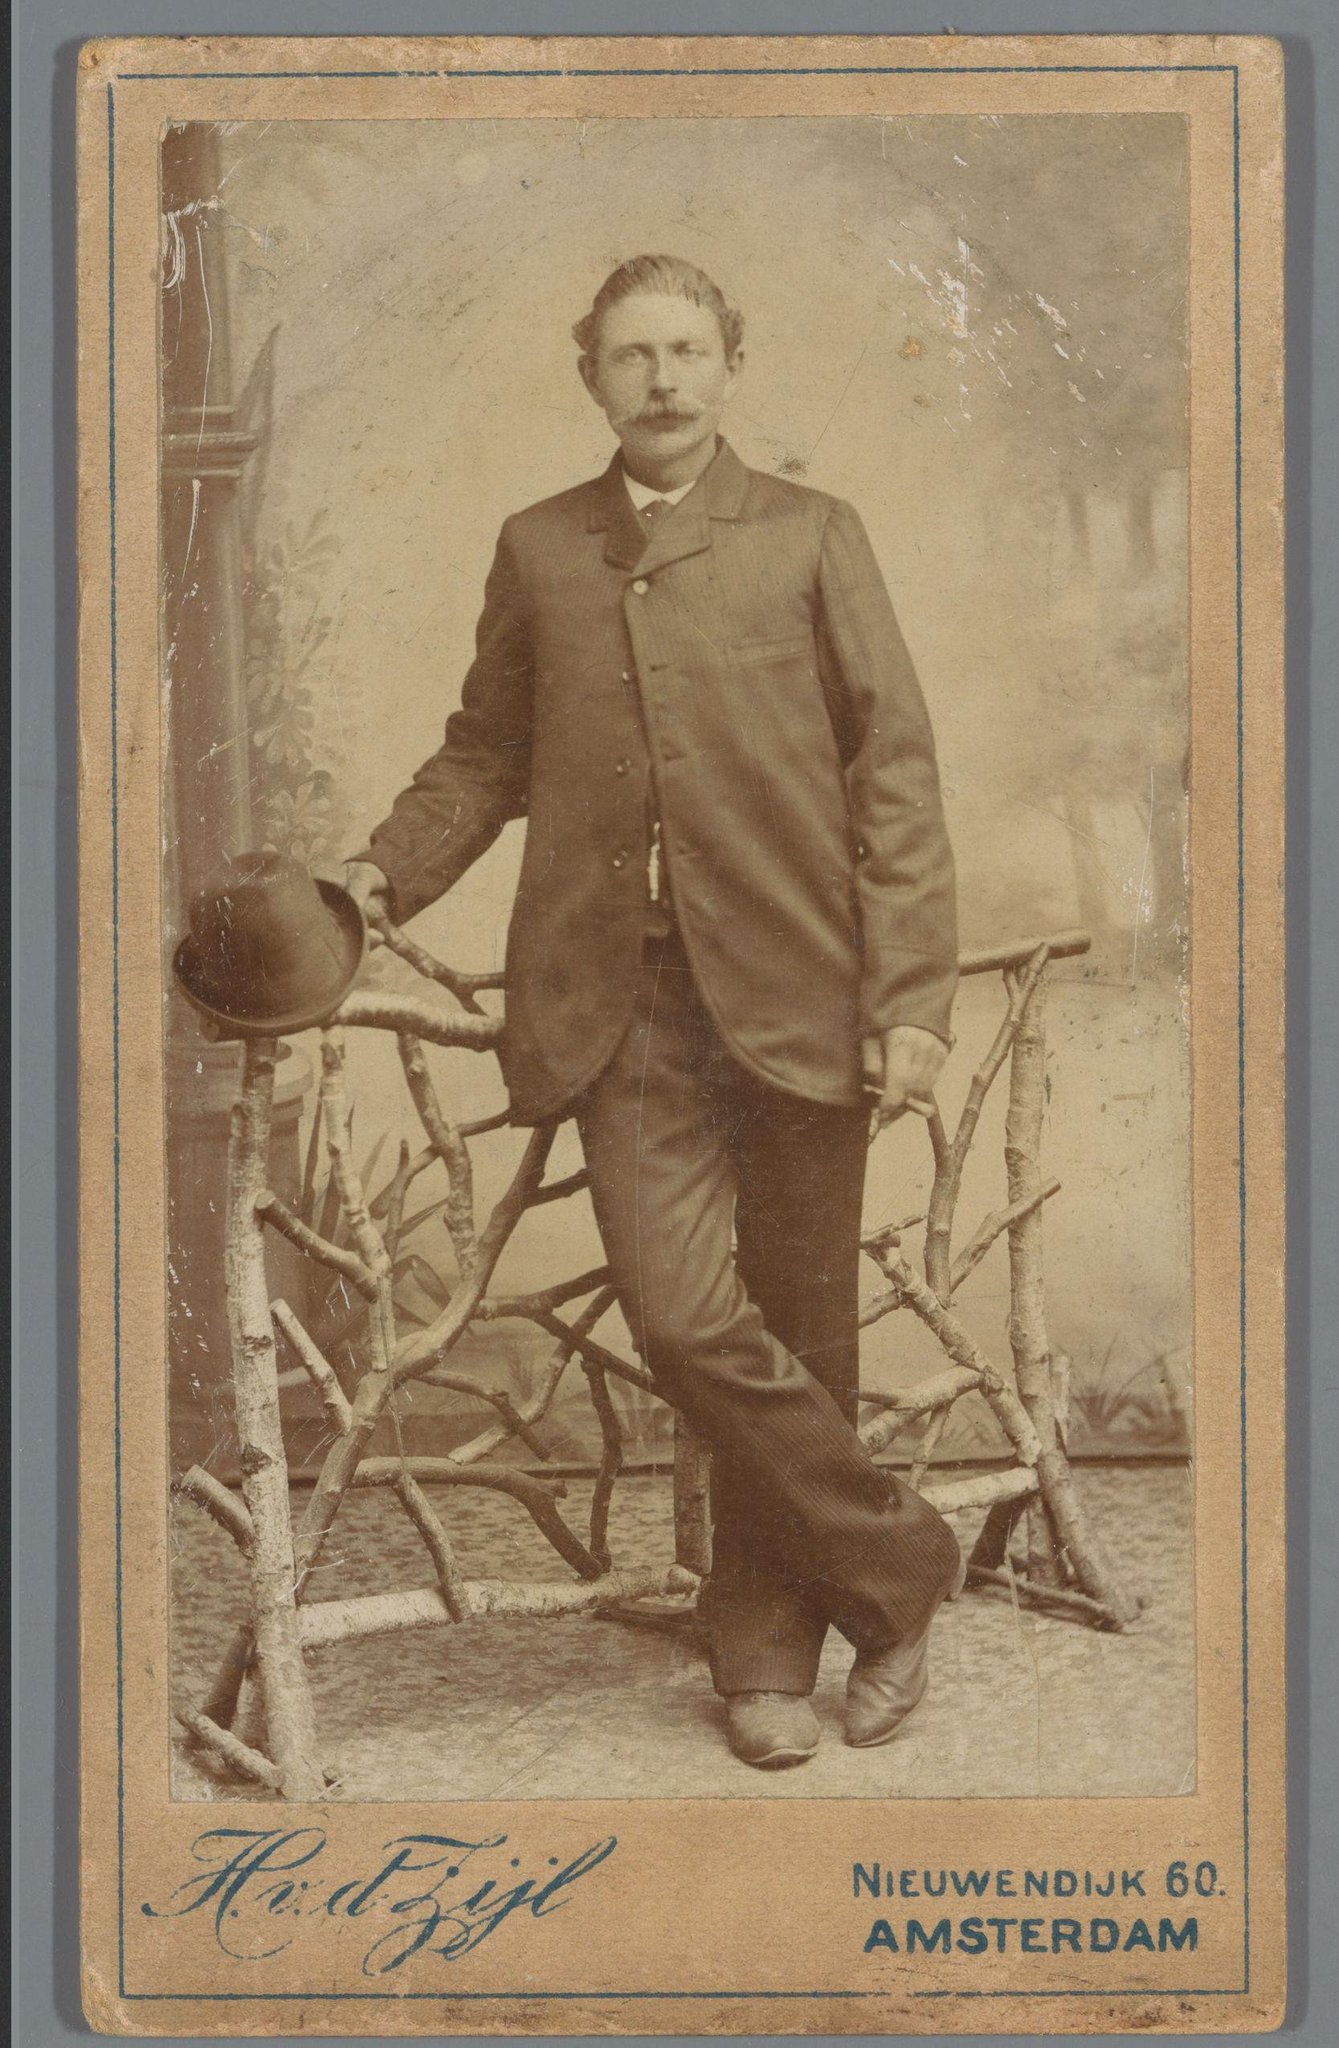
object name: carte de visite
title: Portret van een onbekende man met hoed bij een hek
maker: h. van der zijl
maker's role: fotograaf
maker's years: 1852-1937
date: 1886-1908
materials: paper, cardboard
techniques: collodion silver print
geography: amsterdam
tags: adult woman, anonymous historical person portrayed, amsterdam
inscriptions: inscription: ‘H. v.d. Zijl/ Nieuwendijk 60./ Amsterdam’, inscription: ‘Photographie/ Parisienne/ H. van der Zijl/ Amsterdam/ 60 Nieuwendijk 60/ over Raamskooi en Kapelsteeg./ Gelieve op voornaam H/ en Huisnummer 60 te letten./ Prager & Lojda, Berlin./ 18695’